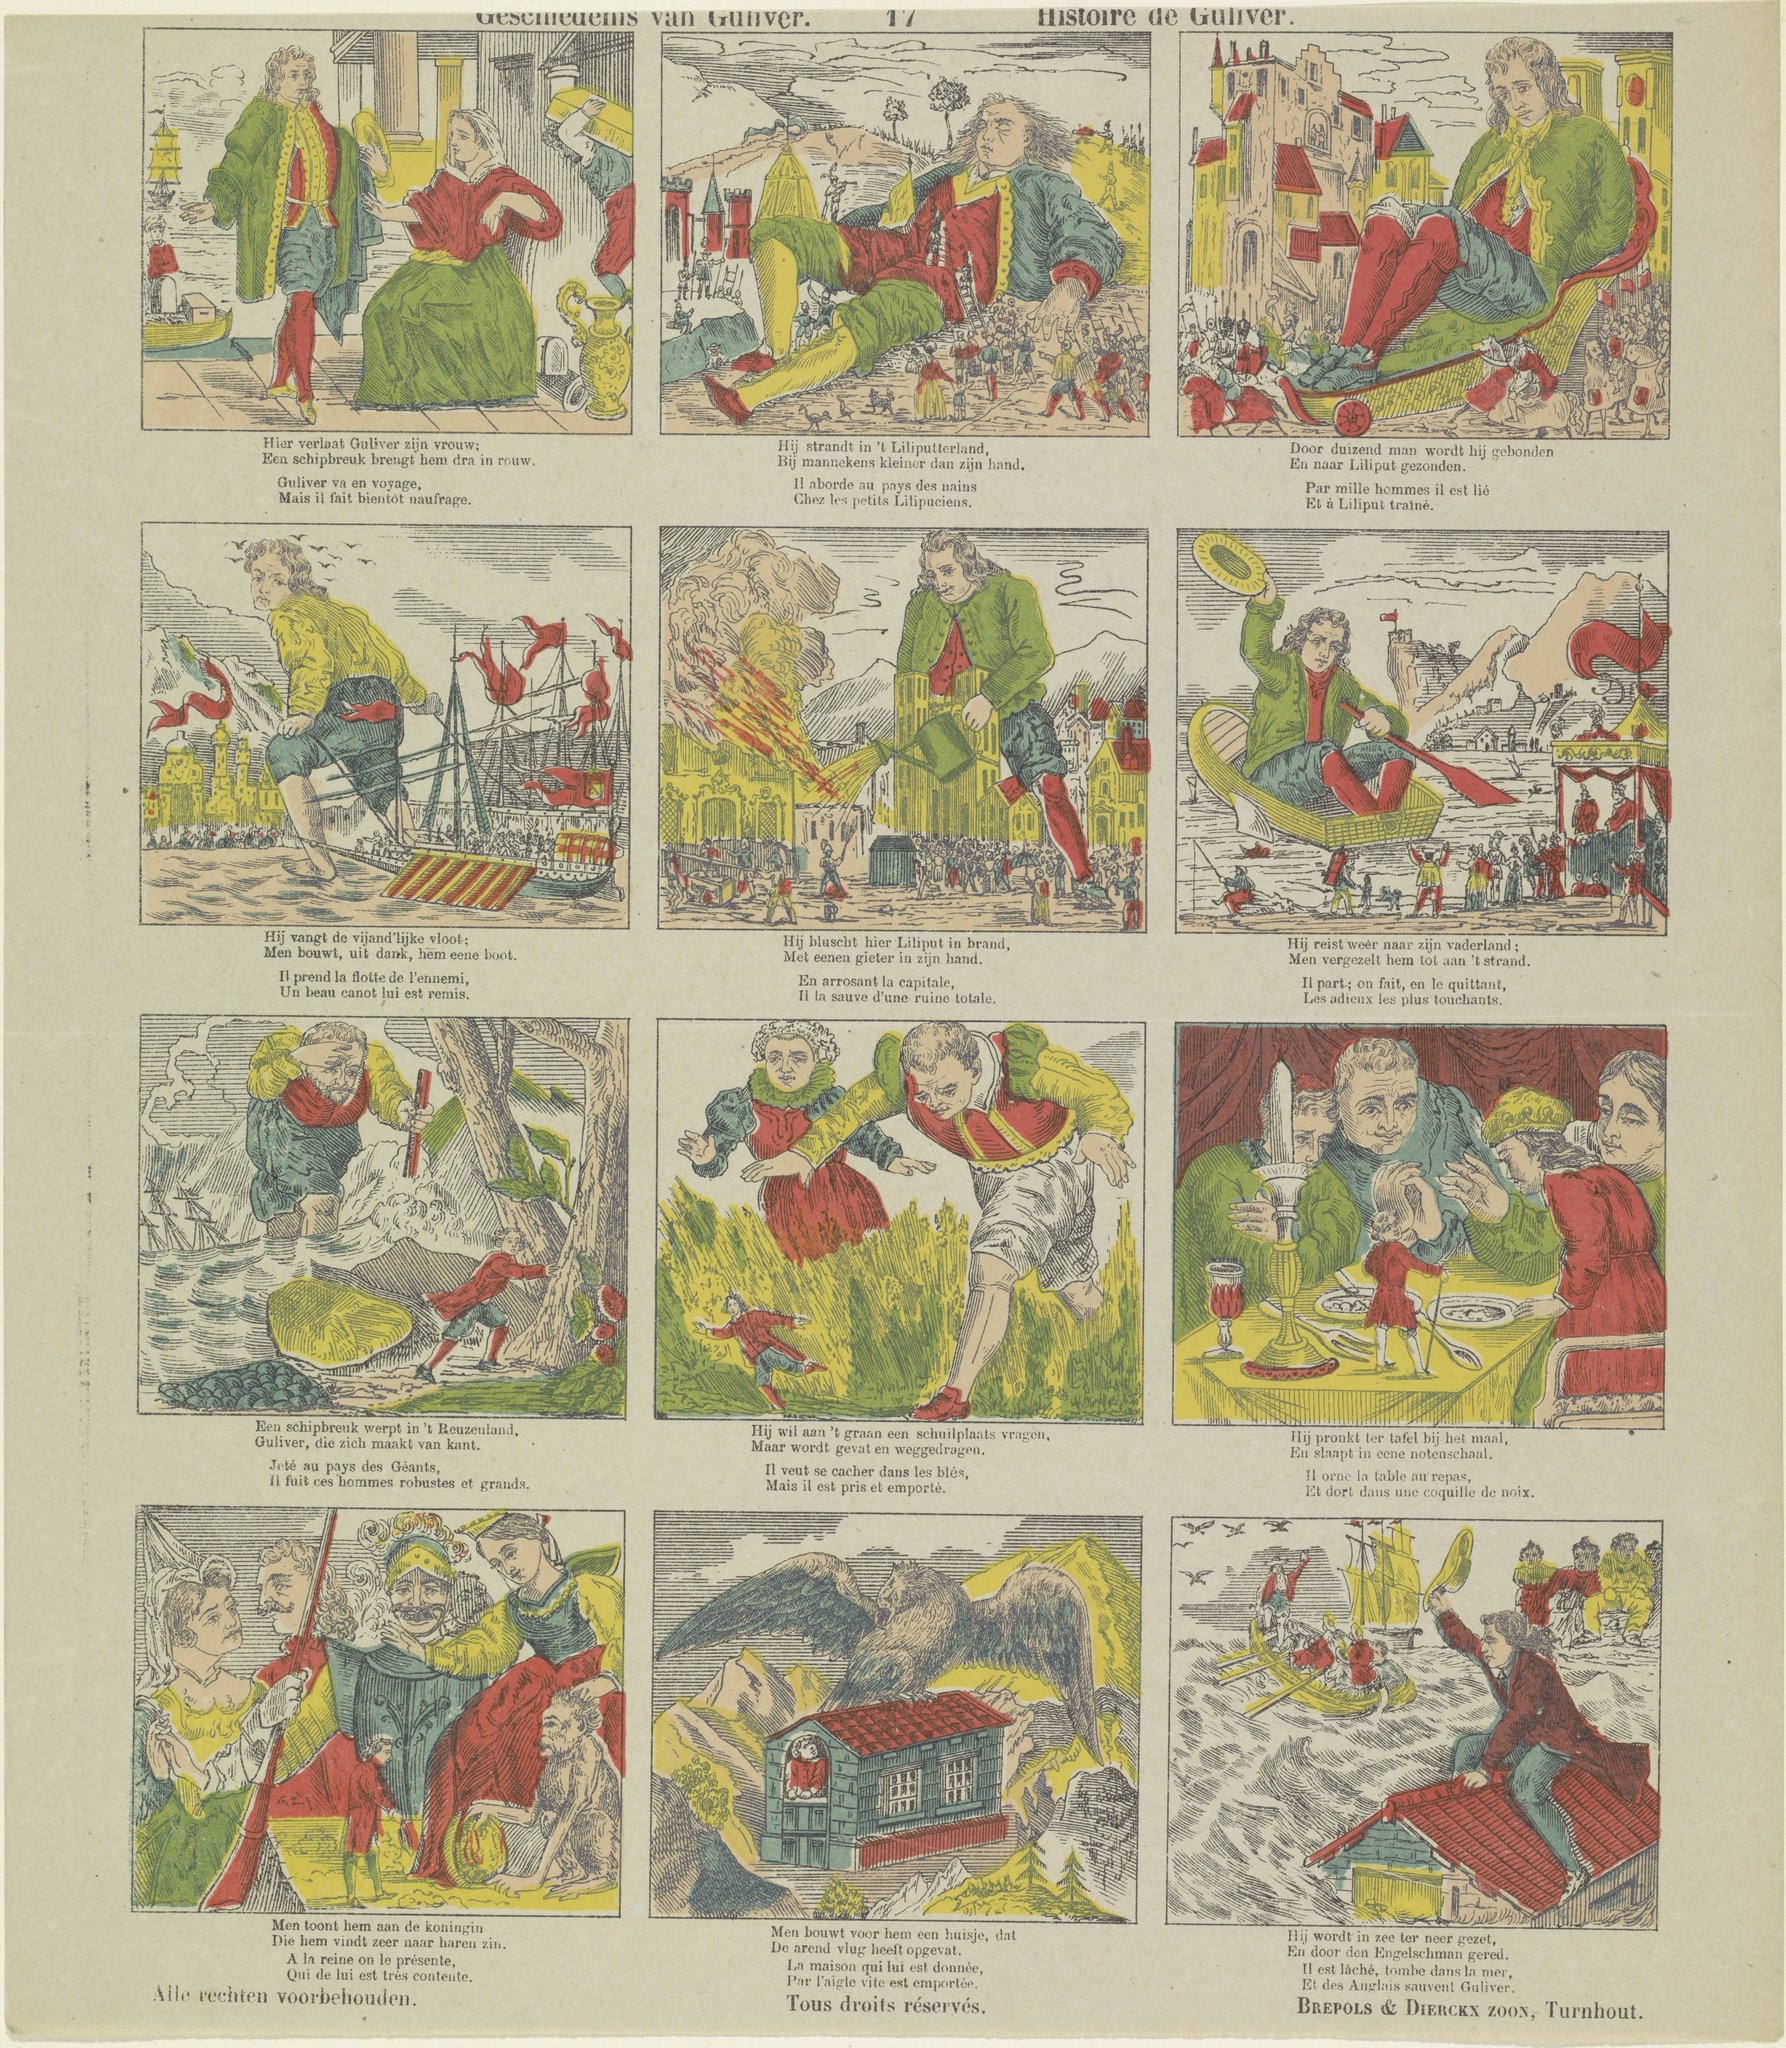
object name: print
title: Geschiedenis van Guliver / Histoire de Guliver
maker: Anonymous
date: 1833-1911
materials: paper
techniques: lithograph, letterpress printing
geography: turnhout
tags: (scenes from) specific works of literature: swift, gulliver's travels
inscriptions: collector's mark: Lugt 2760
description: Blad met 12 voorstellingen uit Gullivers reizen, waaronder Gulliver in Lilliput en twee reuzen die Gulliver gevangennemen. Onder elke voorstelling een tweeregelig vers in het Nederlands en het Frans. Genummerd midden boven: 17.